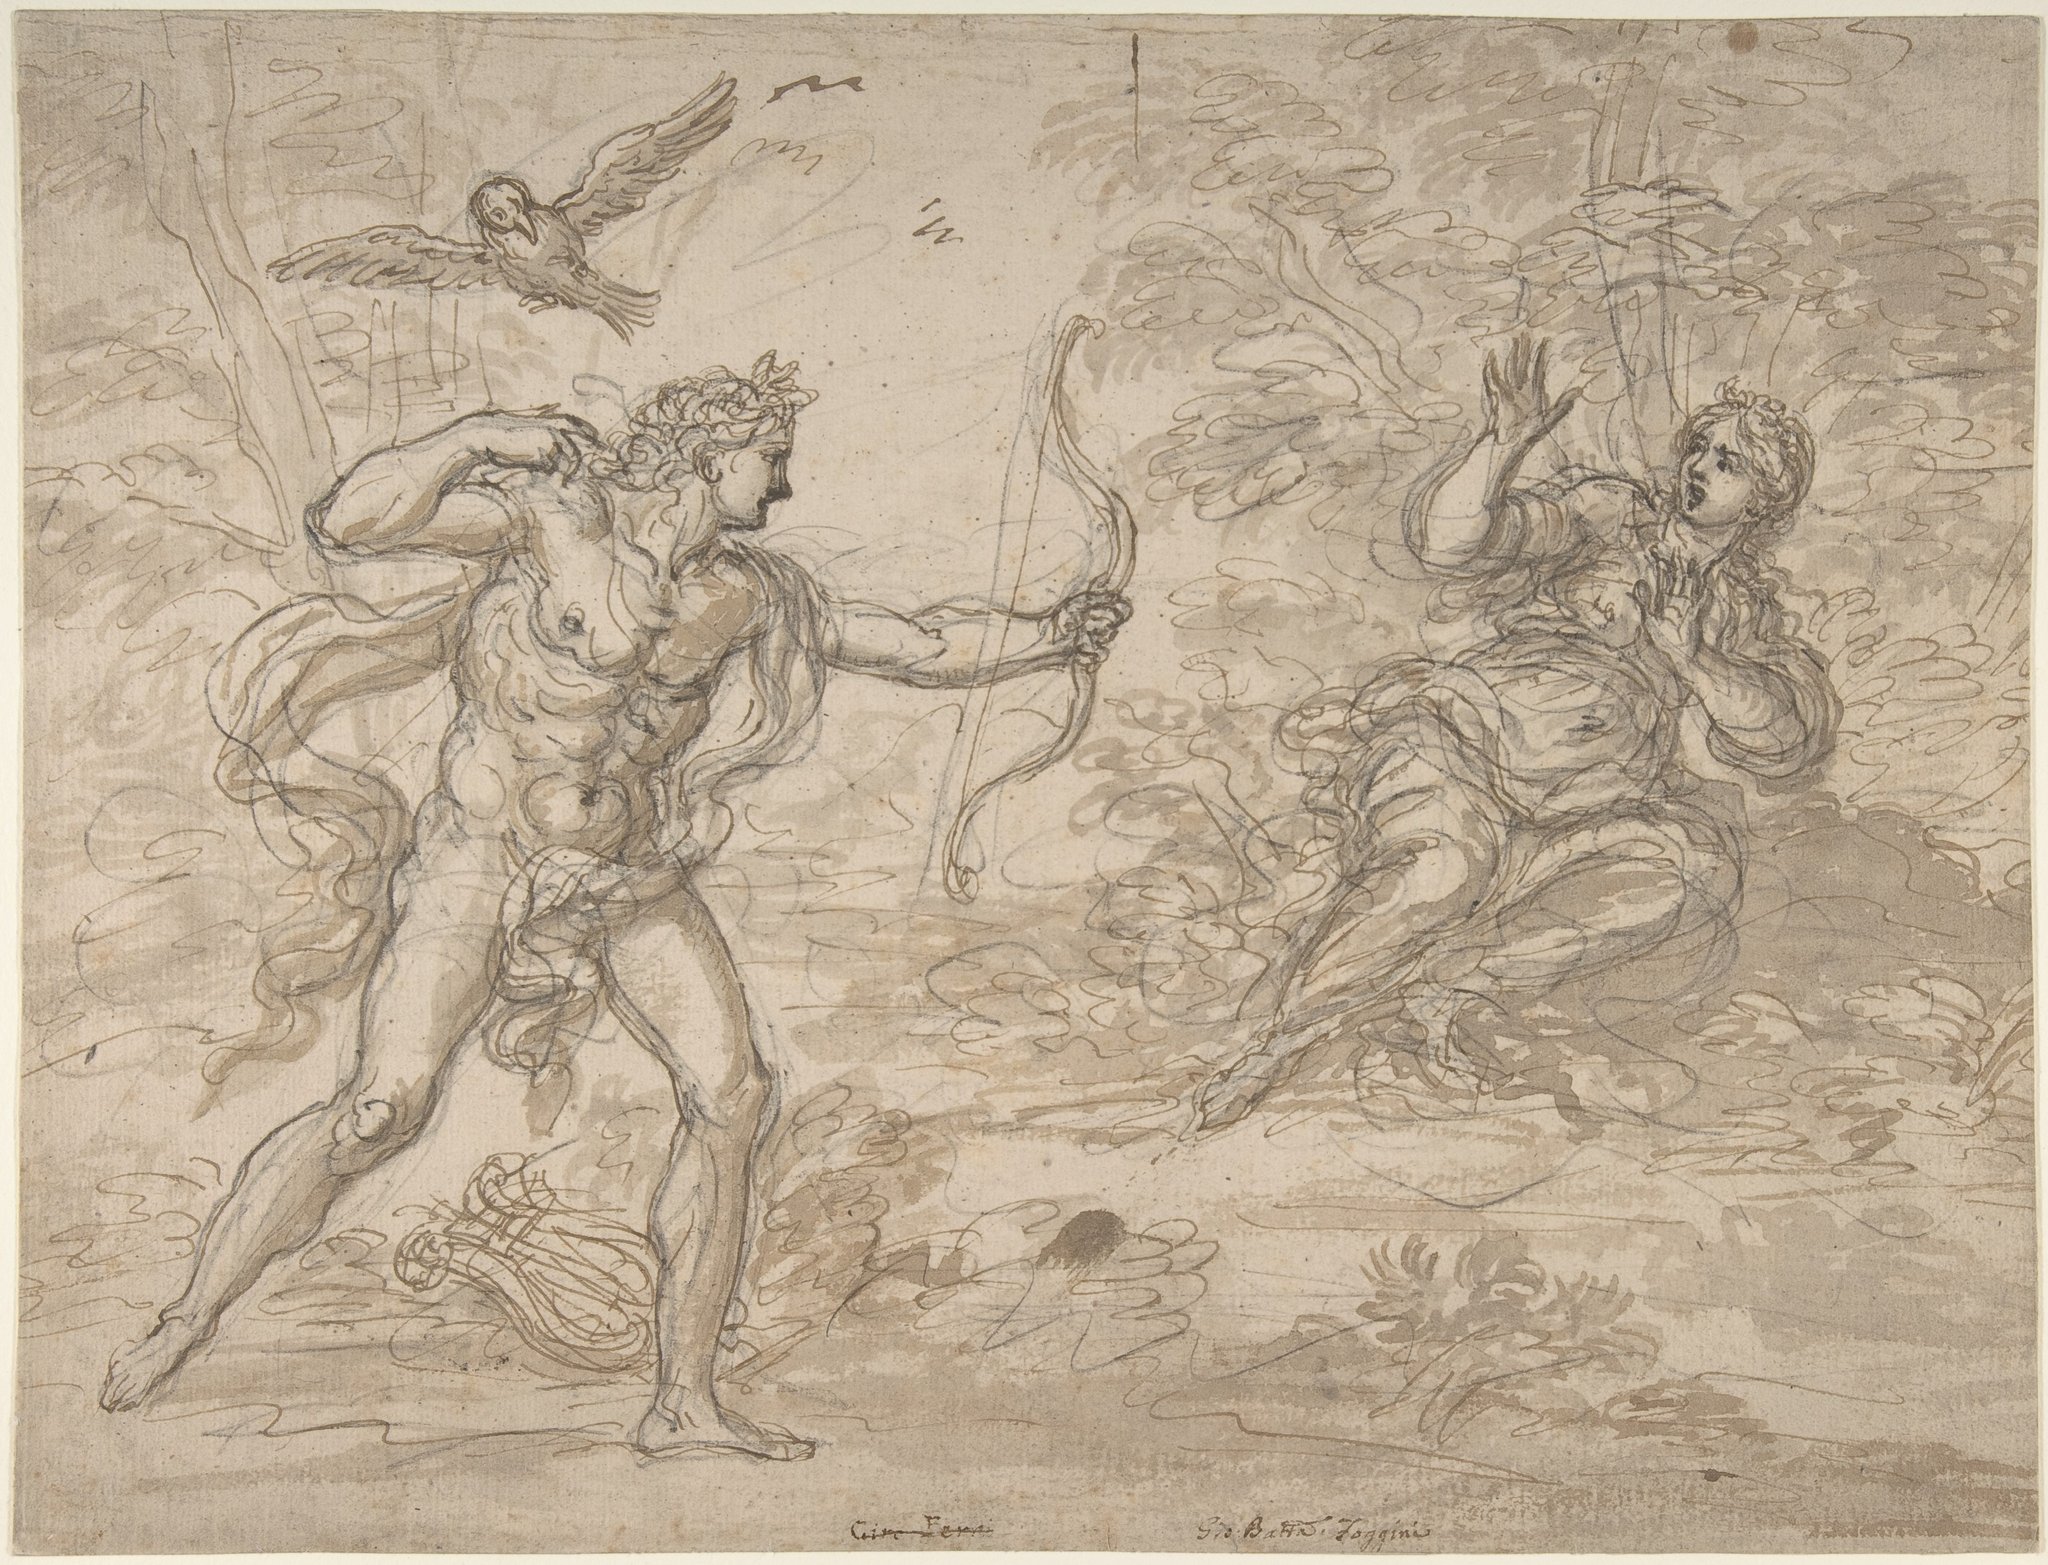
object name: drawing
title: Apollo and Coronis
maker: giovanni battista foggini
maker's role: artist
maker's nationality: italian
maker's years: 1652-1725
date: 1672-1725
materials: chalk, ink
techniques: brush, pen, wash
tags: birds,bow and arrow,female nudes,apollo